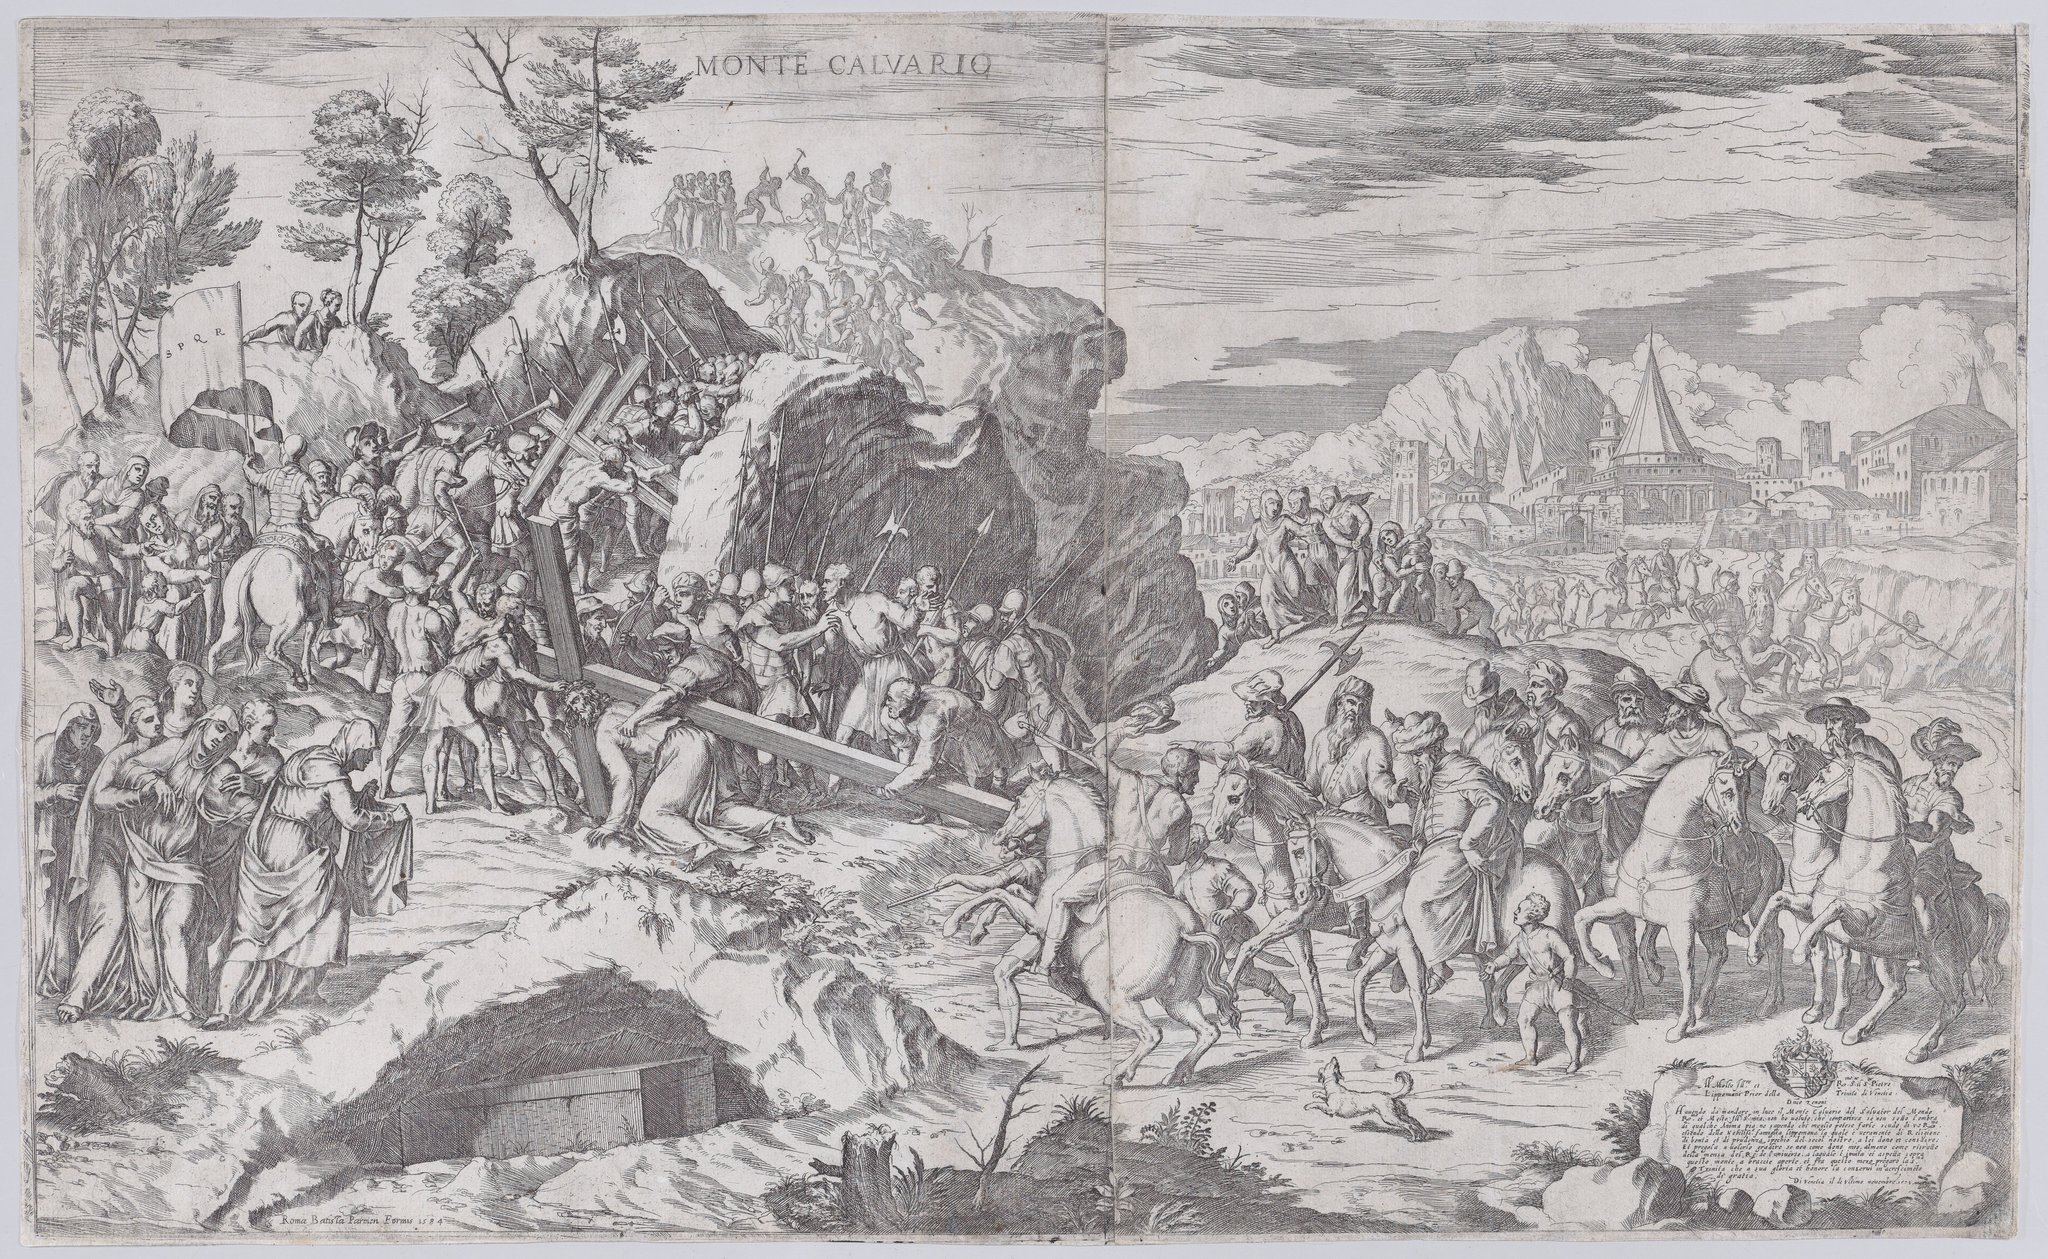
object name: print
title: Christ falling on the road to Calvary, from two plates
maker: giovanni battista fontana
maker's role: artist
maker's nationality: italian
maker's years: 1524-1587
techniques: engraving, etching